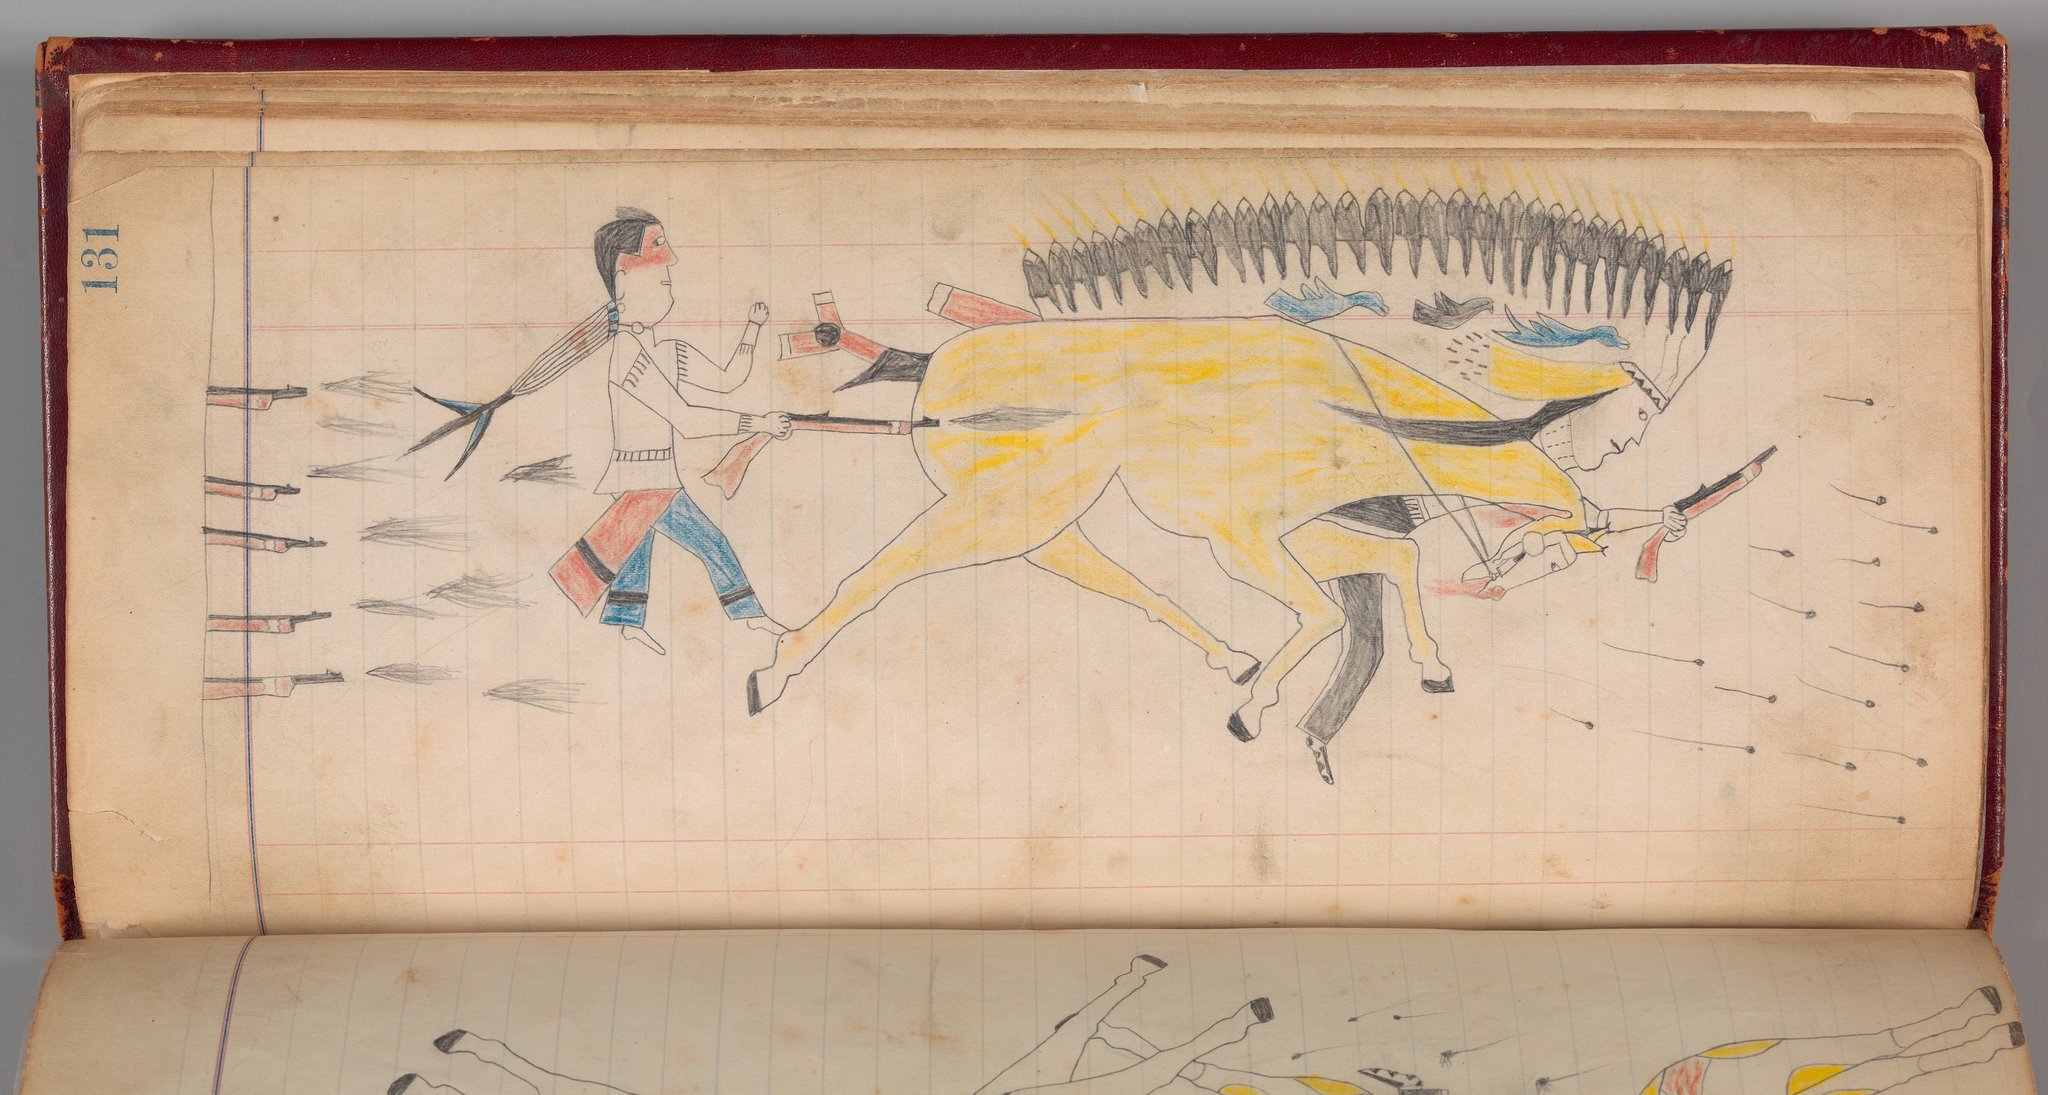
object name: book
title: Maffet Ledger: Drawing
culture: cheyenne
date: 1874-1881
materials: crayon, graphite, paper, watercolor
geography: united states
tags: firearms,men,horses